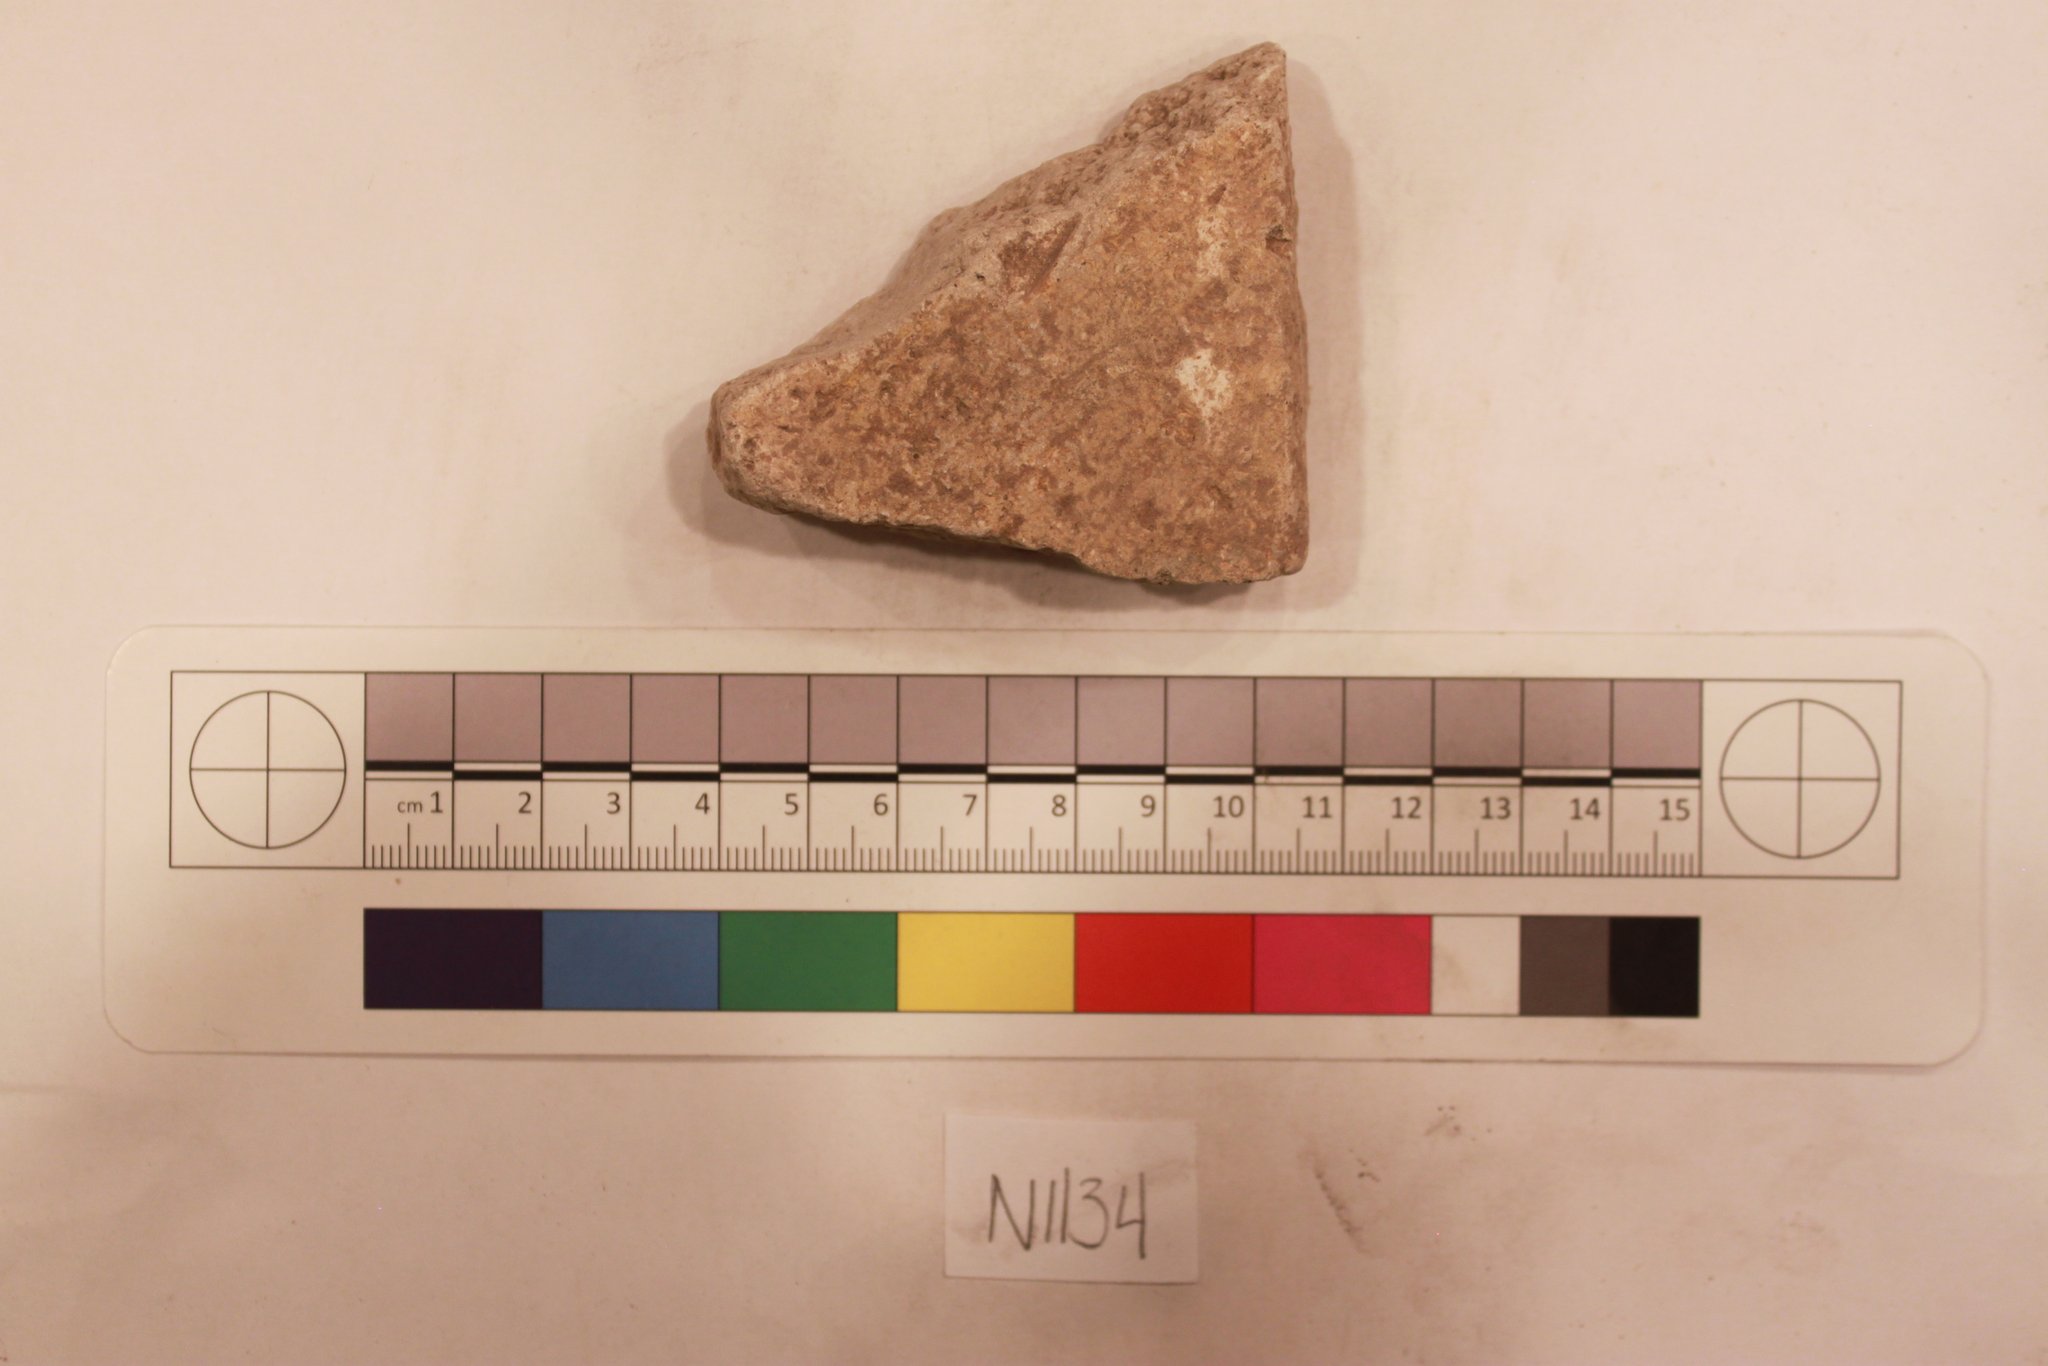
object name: fragment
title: Stucco Fragment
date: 701-1200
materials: plaster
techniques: carving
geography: iran